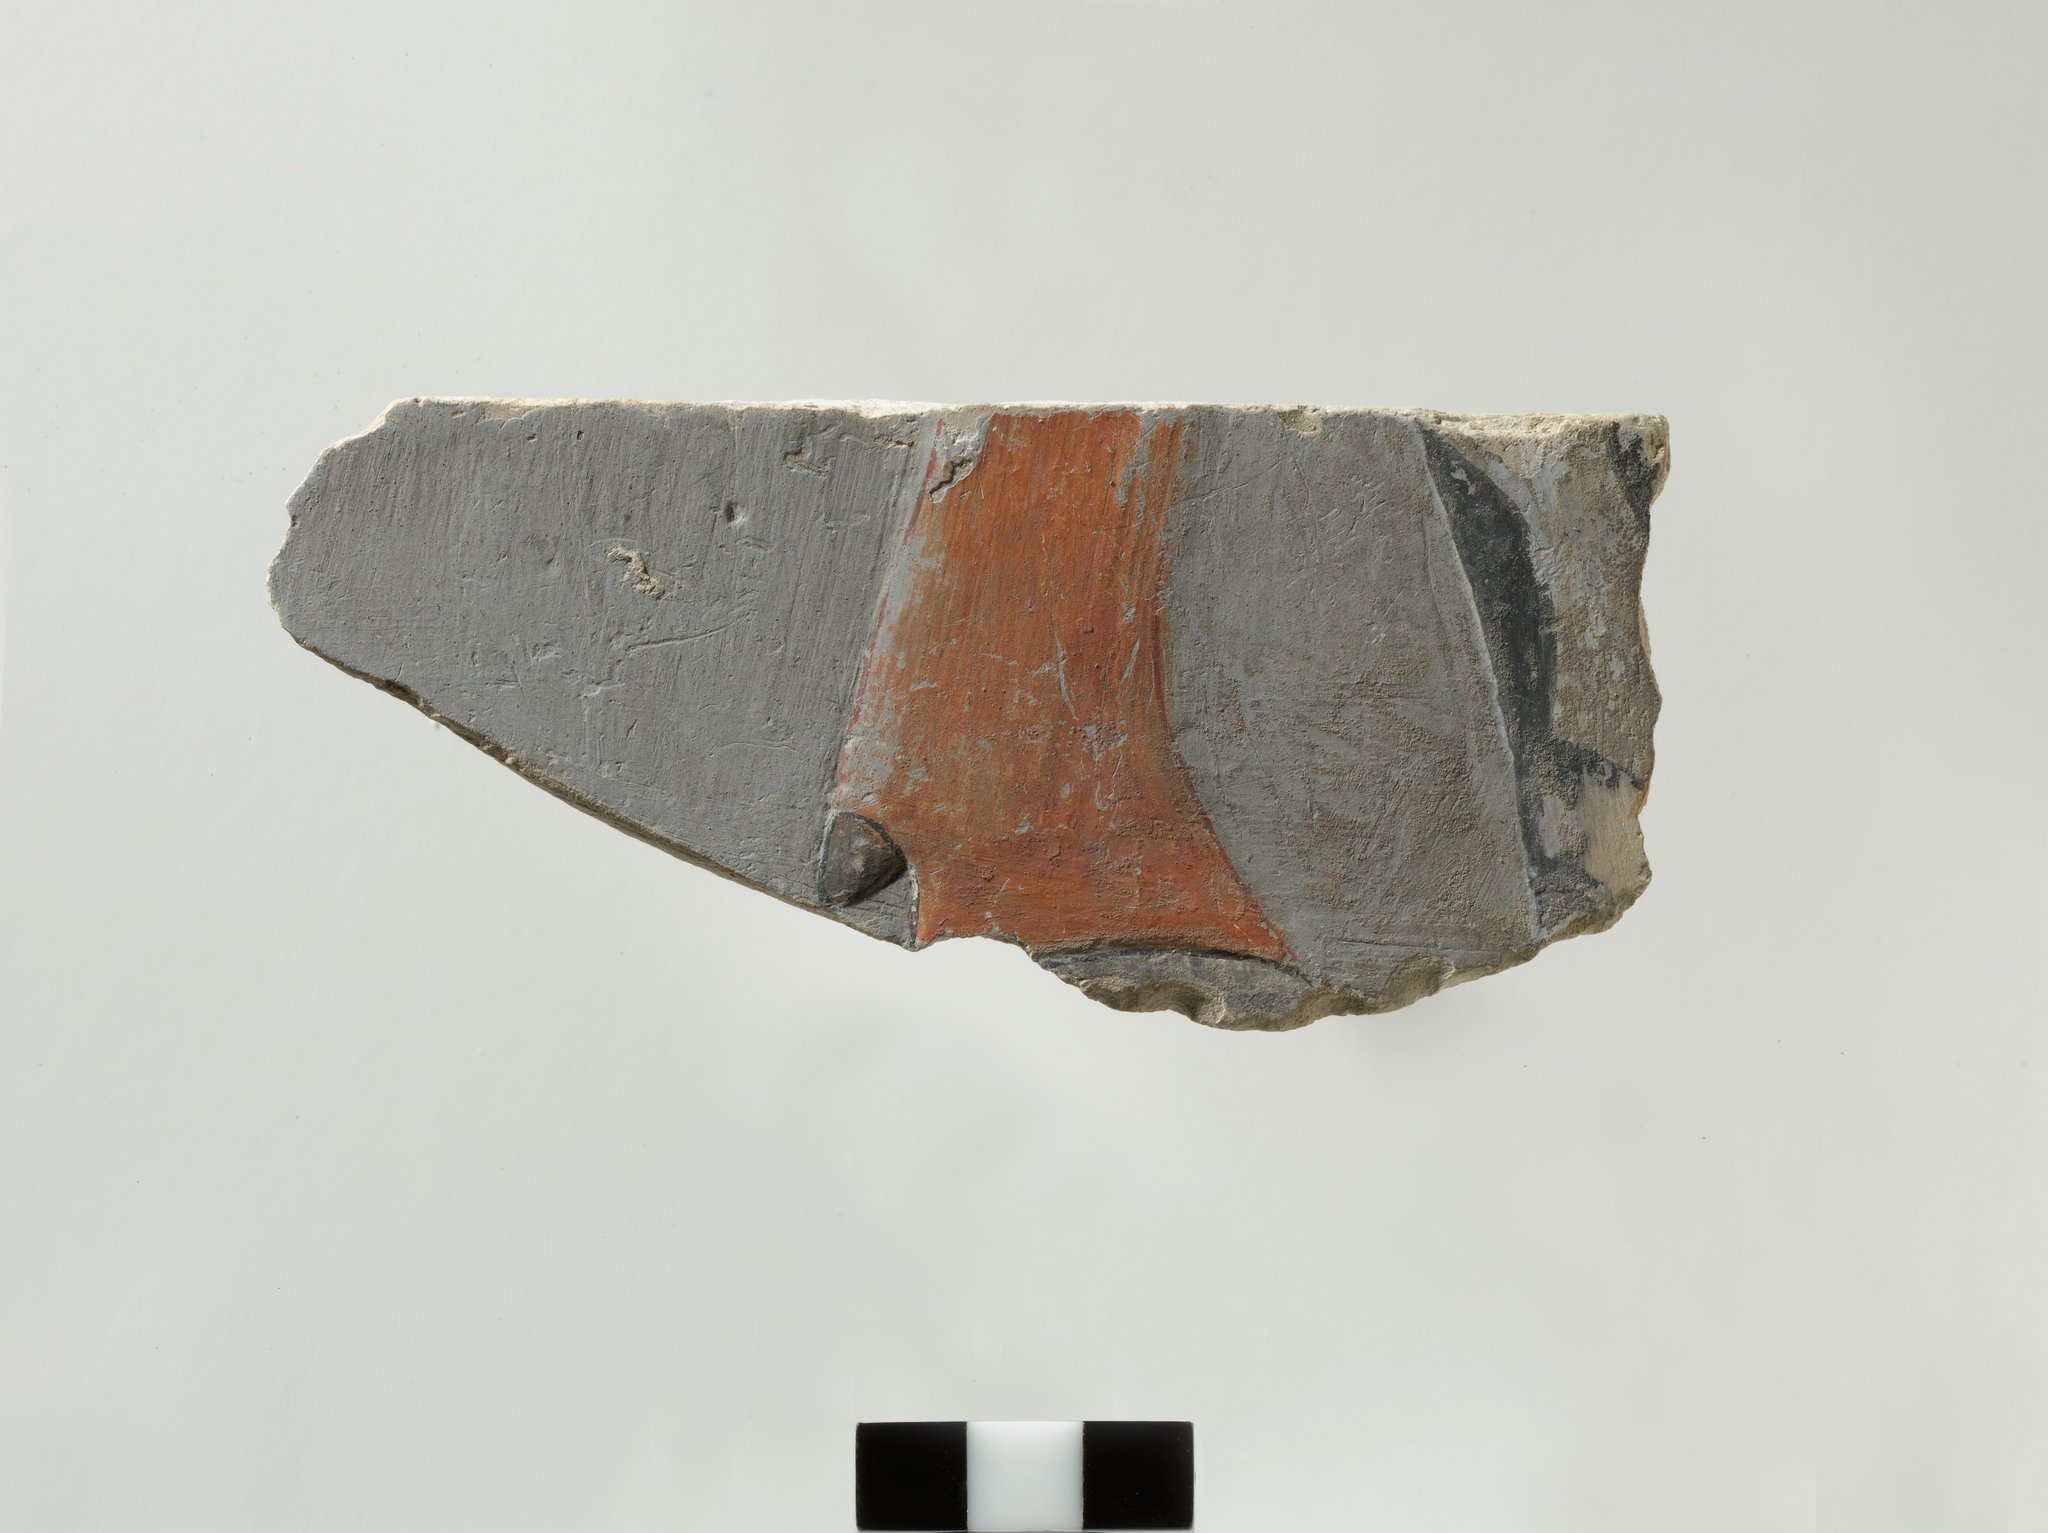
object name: relief fragment, tomb of meketre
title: Relief fragment from tomb of Meketre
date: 1981-1975 BCE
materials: limestone, paint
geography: egypt